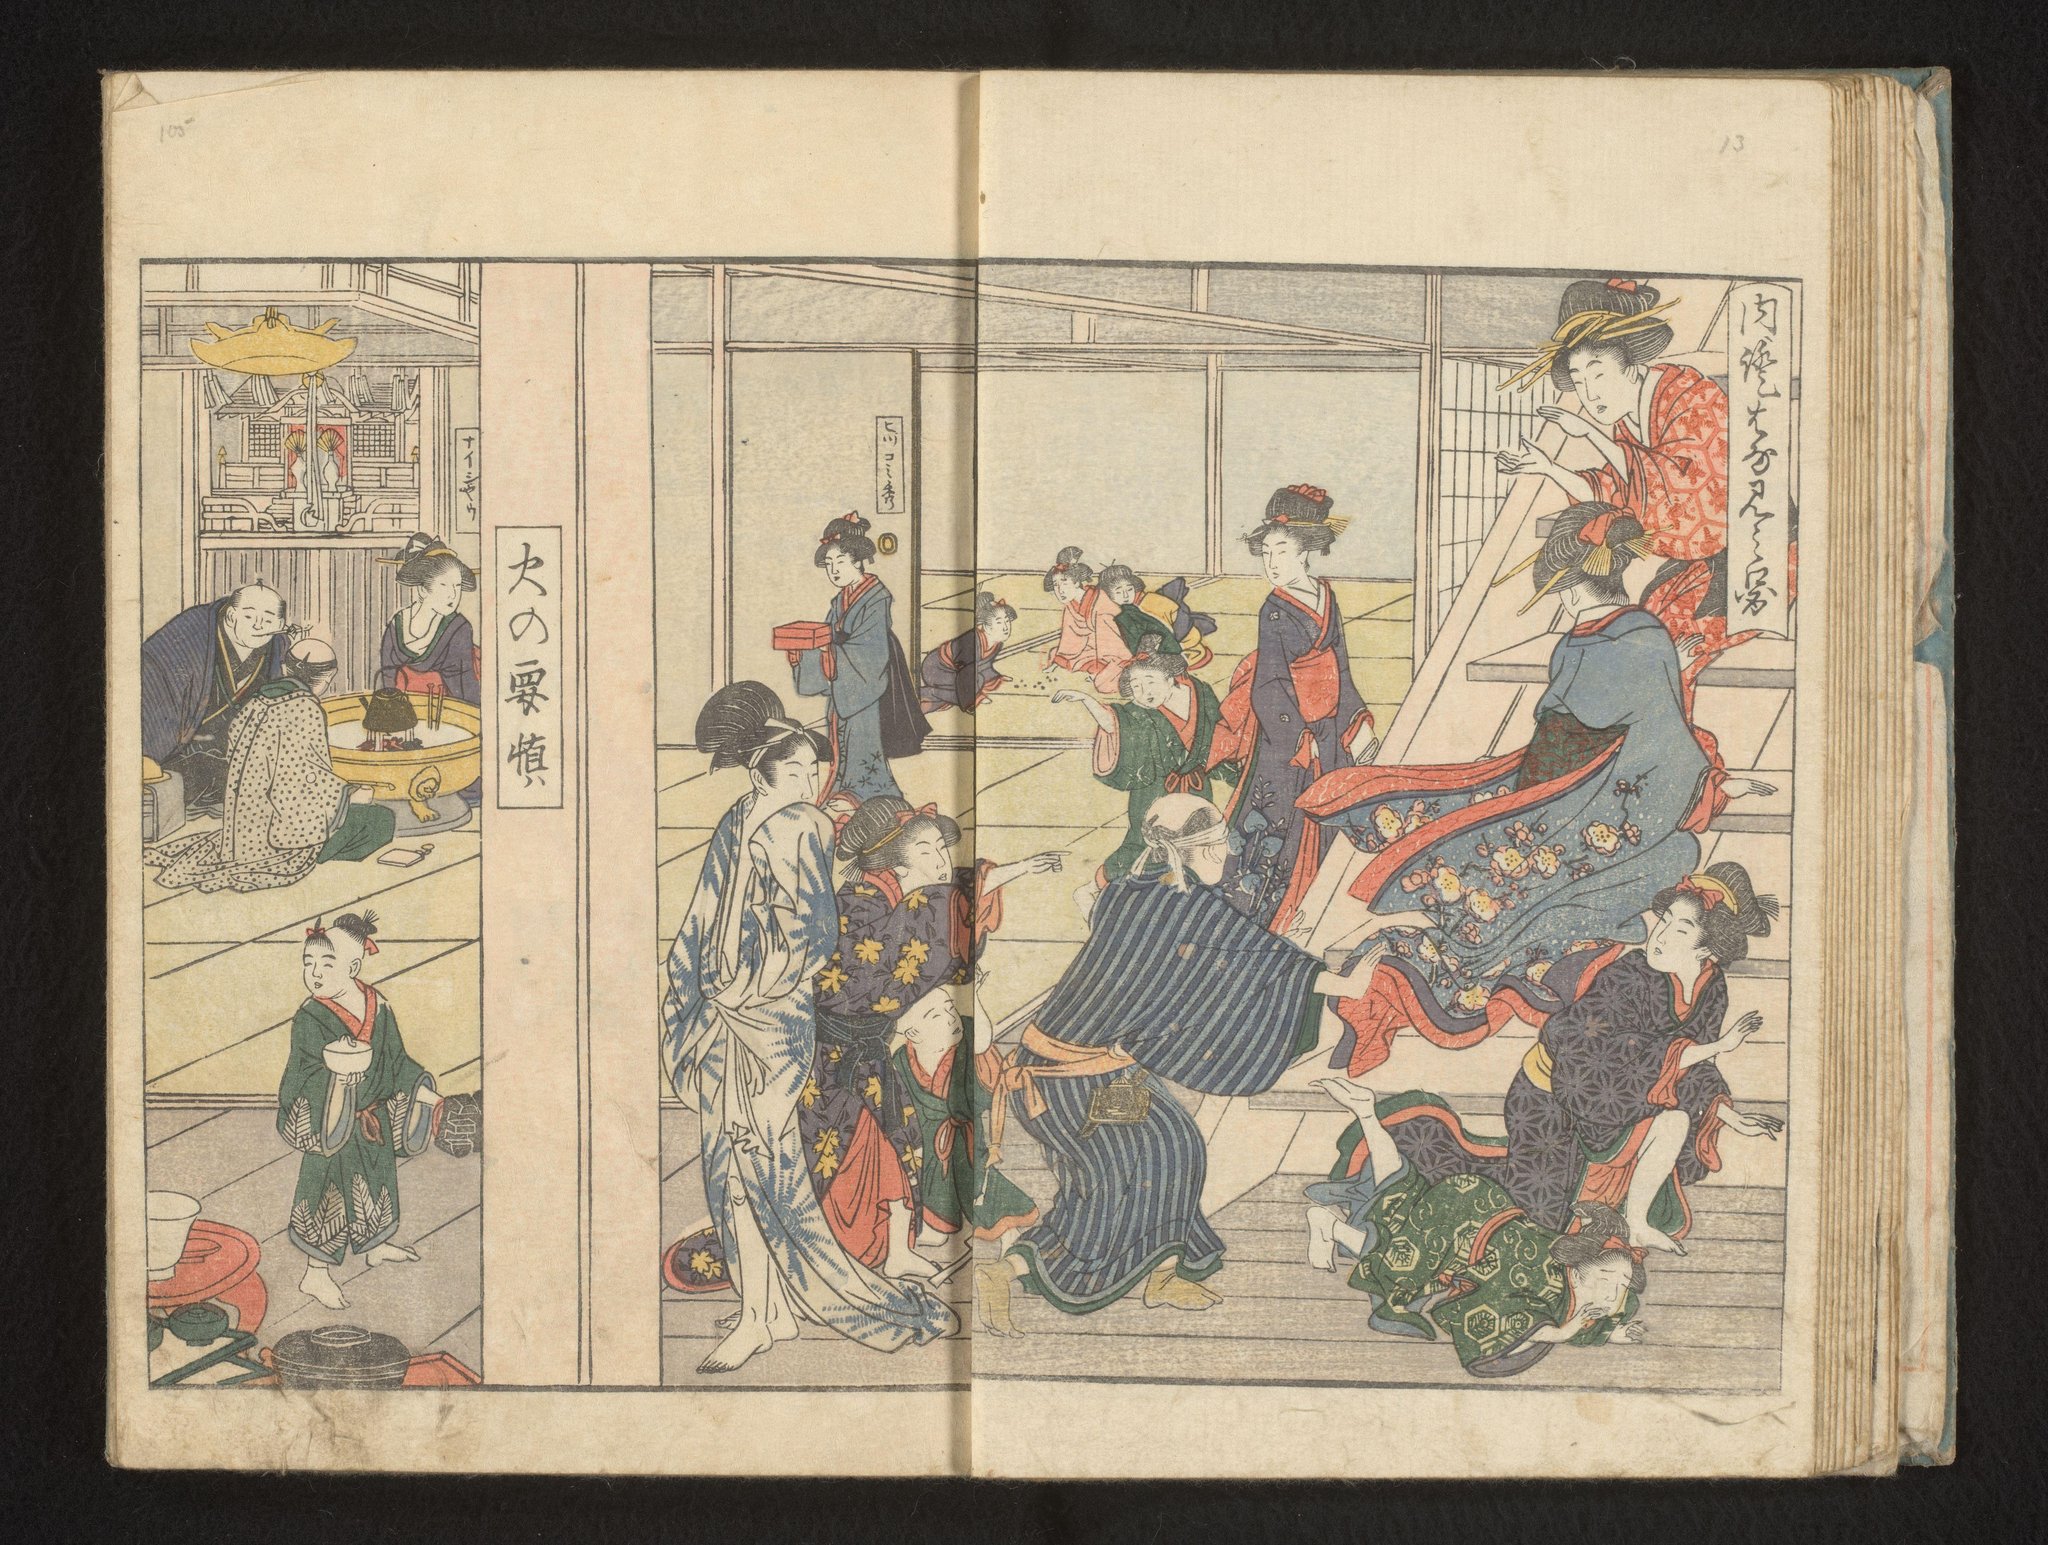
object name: page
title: Blindemannetje spelen op een vrije dag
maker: kitagawa utamaro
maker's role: print maker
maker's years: 1753-1806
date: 1804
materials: paper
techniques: woodcut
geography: edo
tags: blind-man's buff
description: Pagina 24 en 25 van deel één van Utamaro`s boek: Gebeurtenissen in de lusthuizen gedurende het jaar.